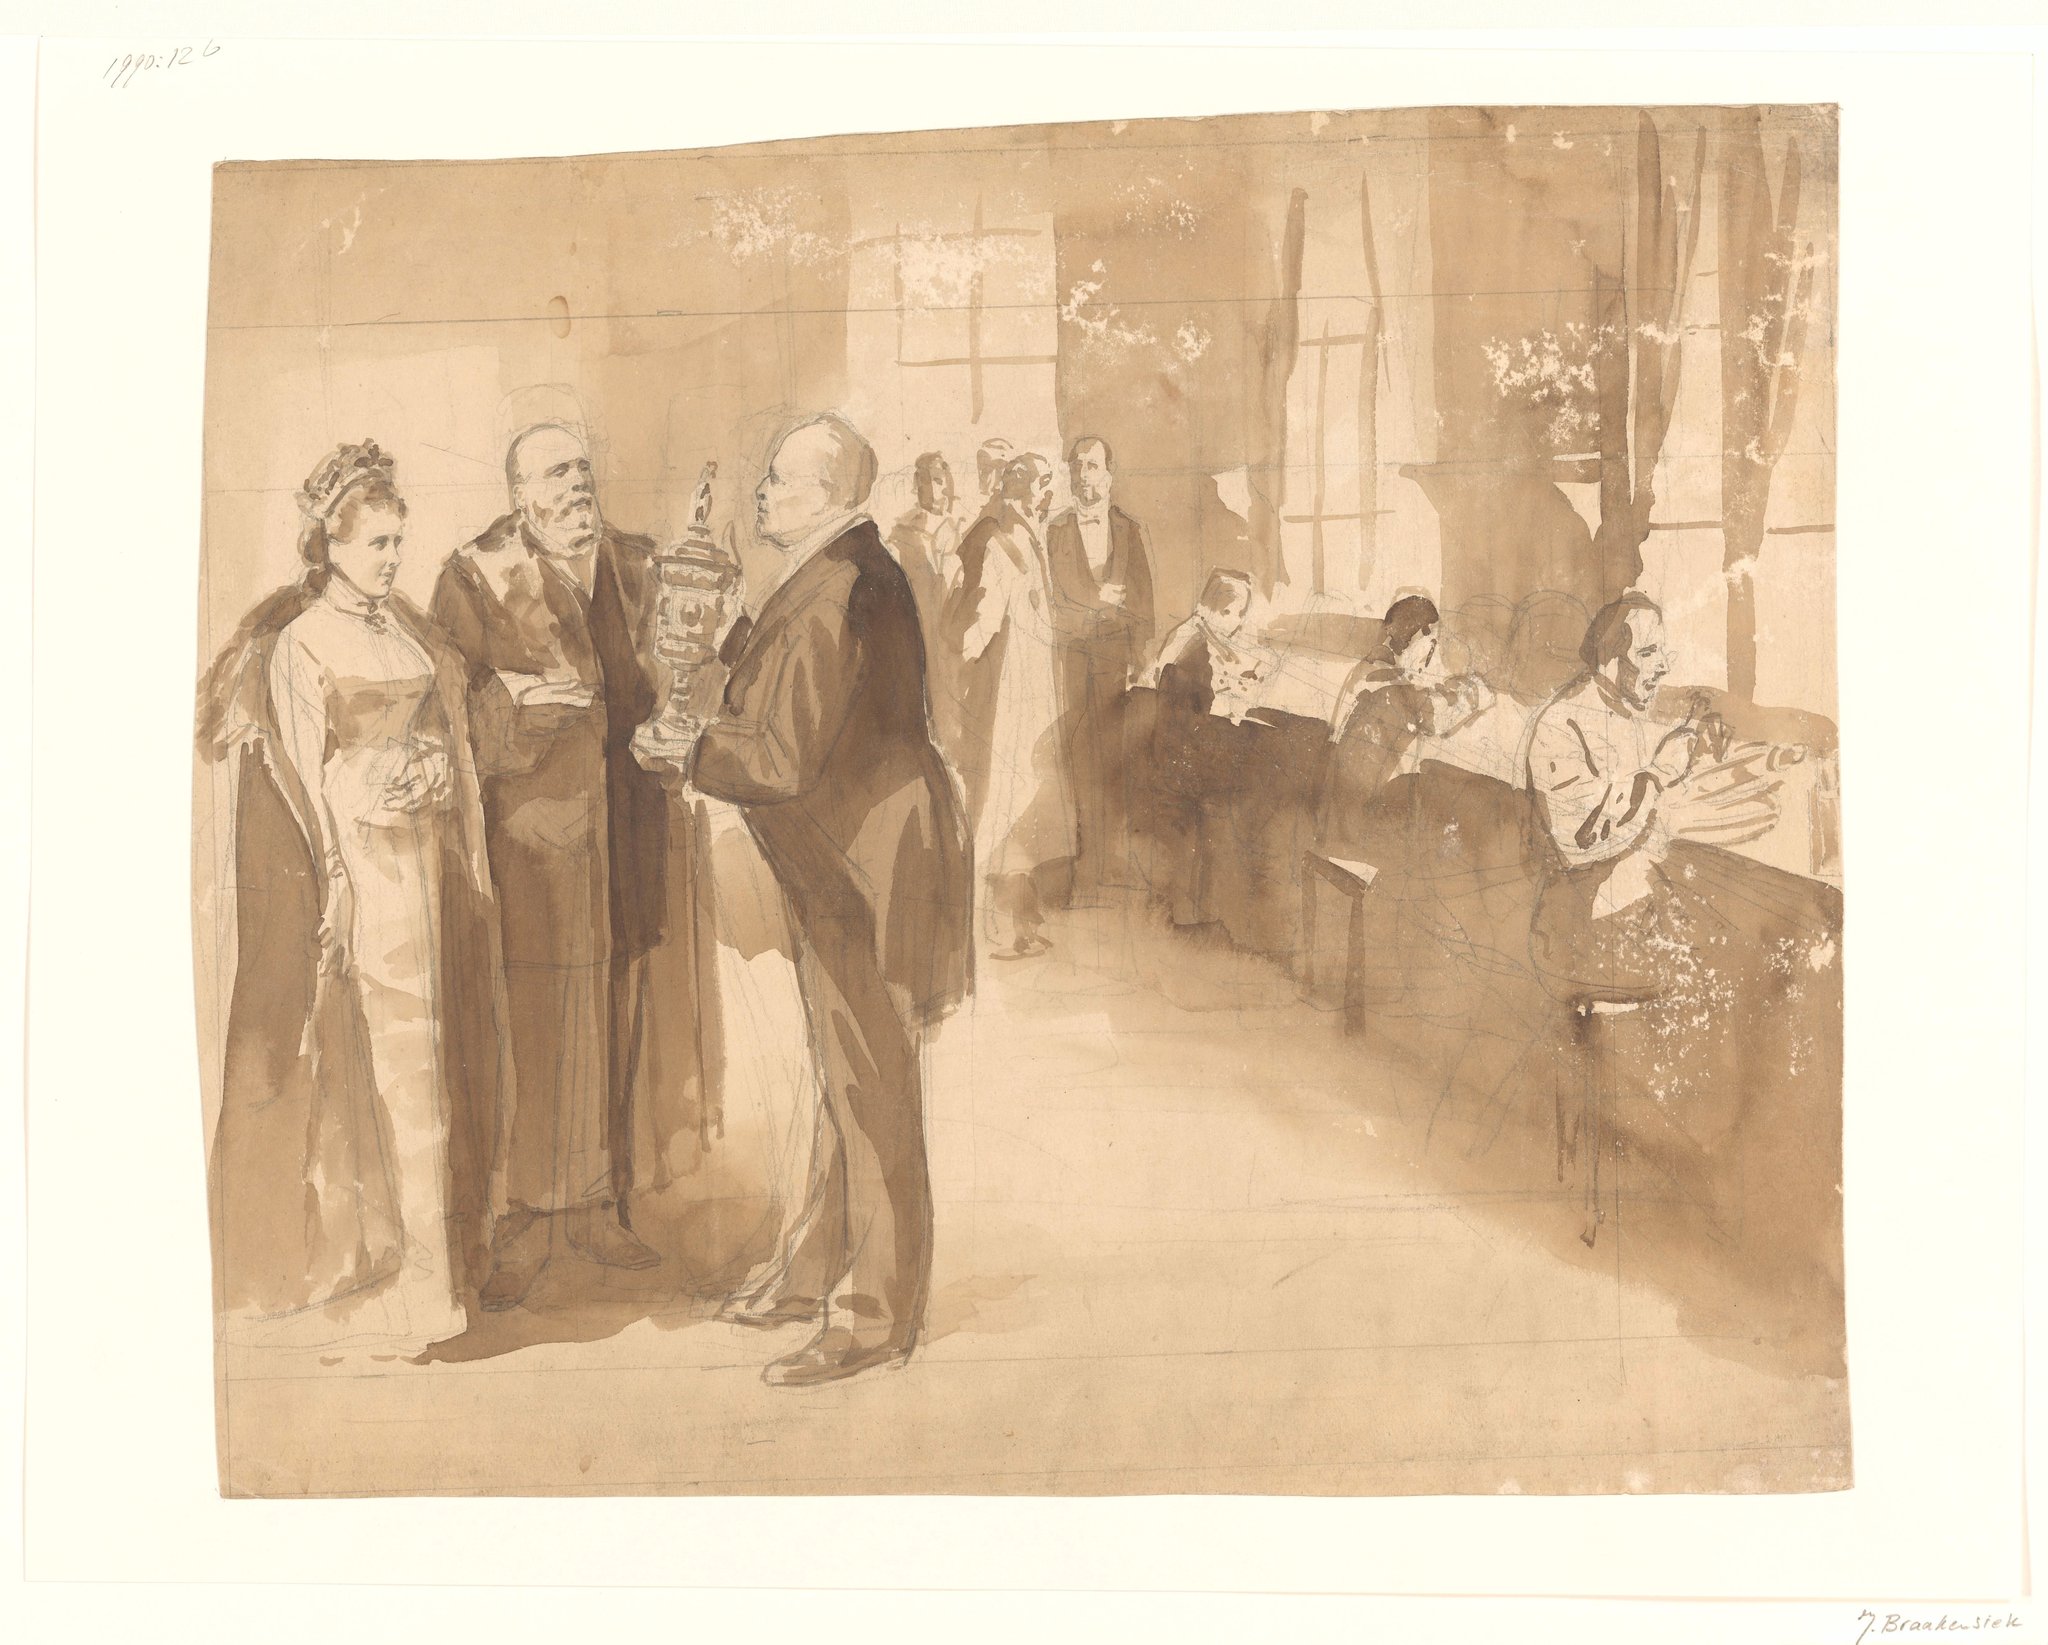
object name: design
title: Koning Willem III en koningin Emma in een werkplaats wordt een pronkbeker getoond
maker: johan braakensiek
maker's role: draughtsman, print maker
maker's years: 1858-1940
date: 1868-1940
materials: paper, pencil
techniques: brush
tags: the hague, emma (queen consort of the netherlands), willem iii (koning der nederlanden), historical persons, political caricatures and satires